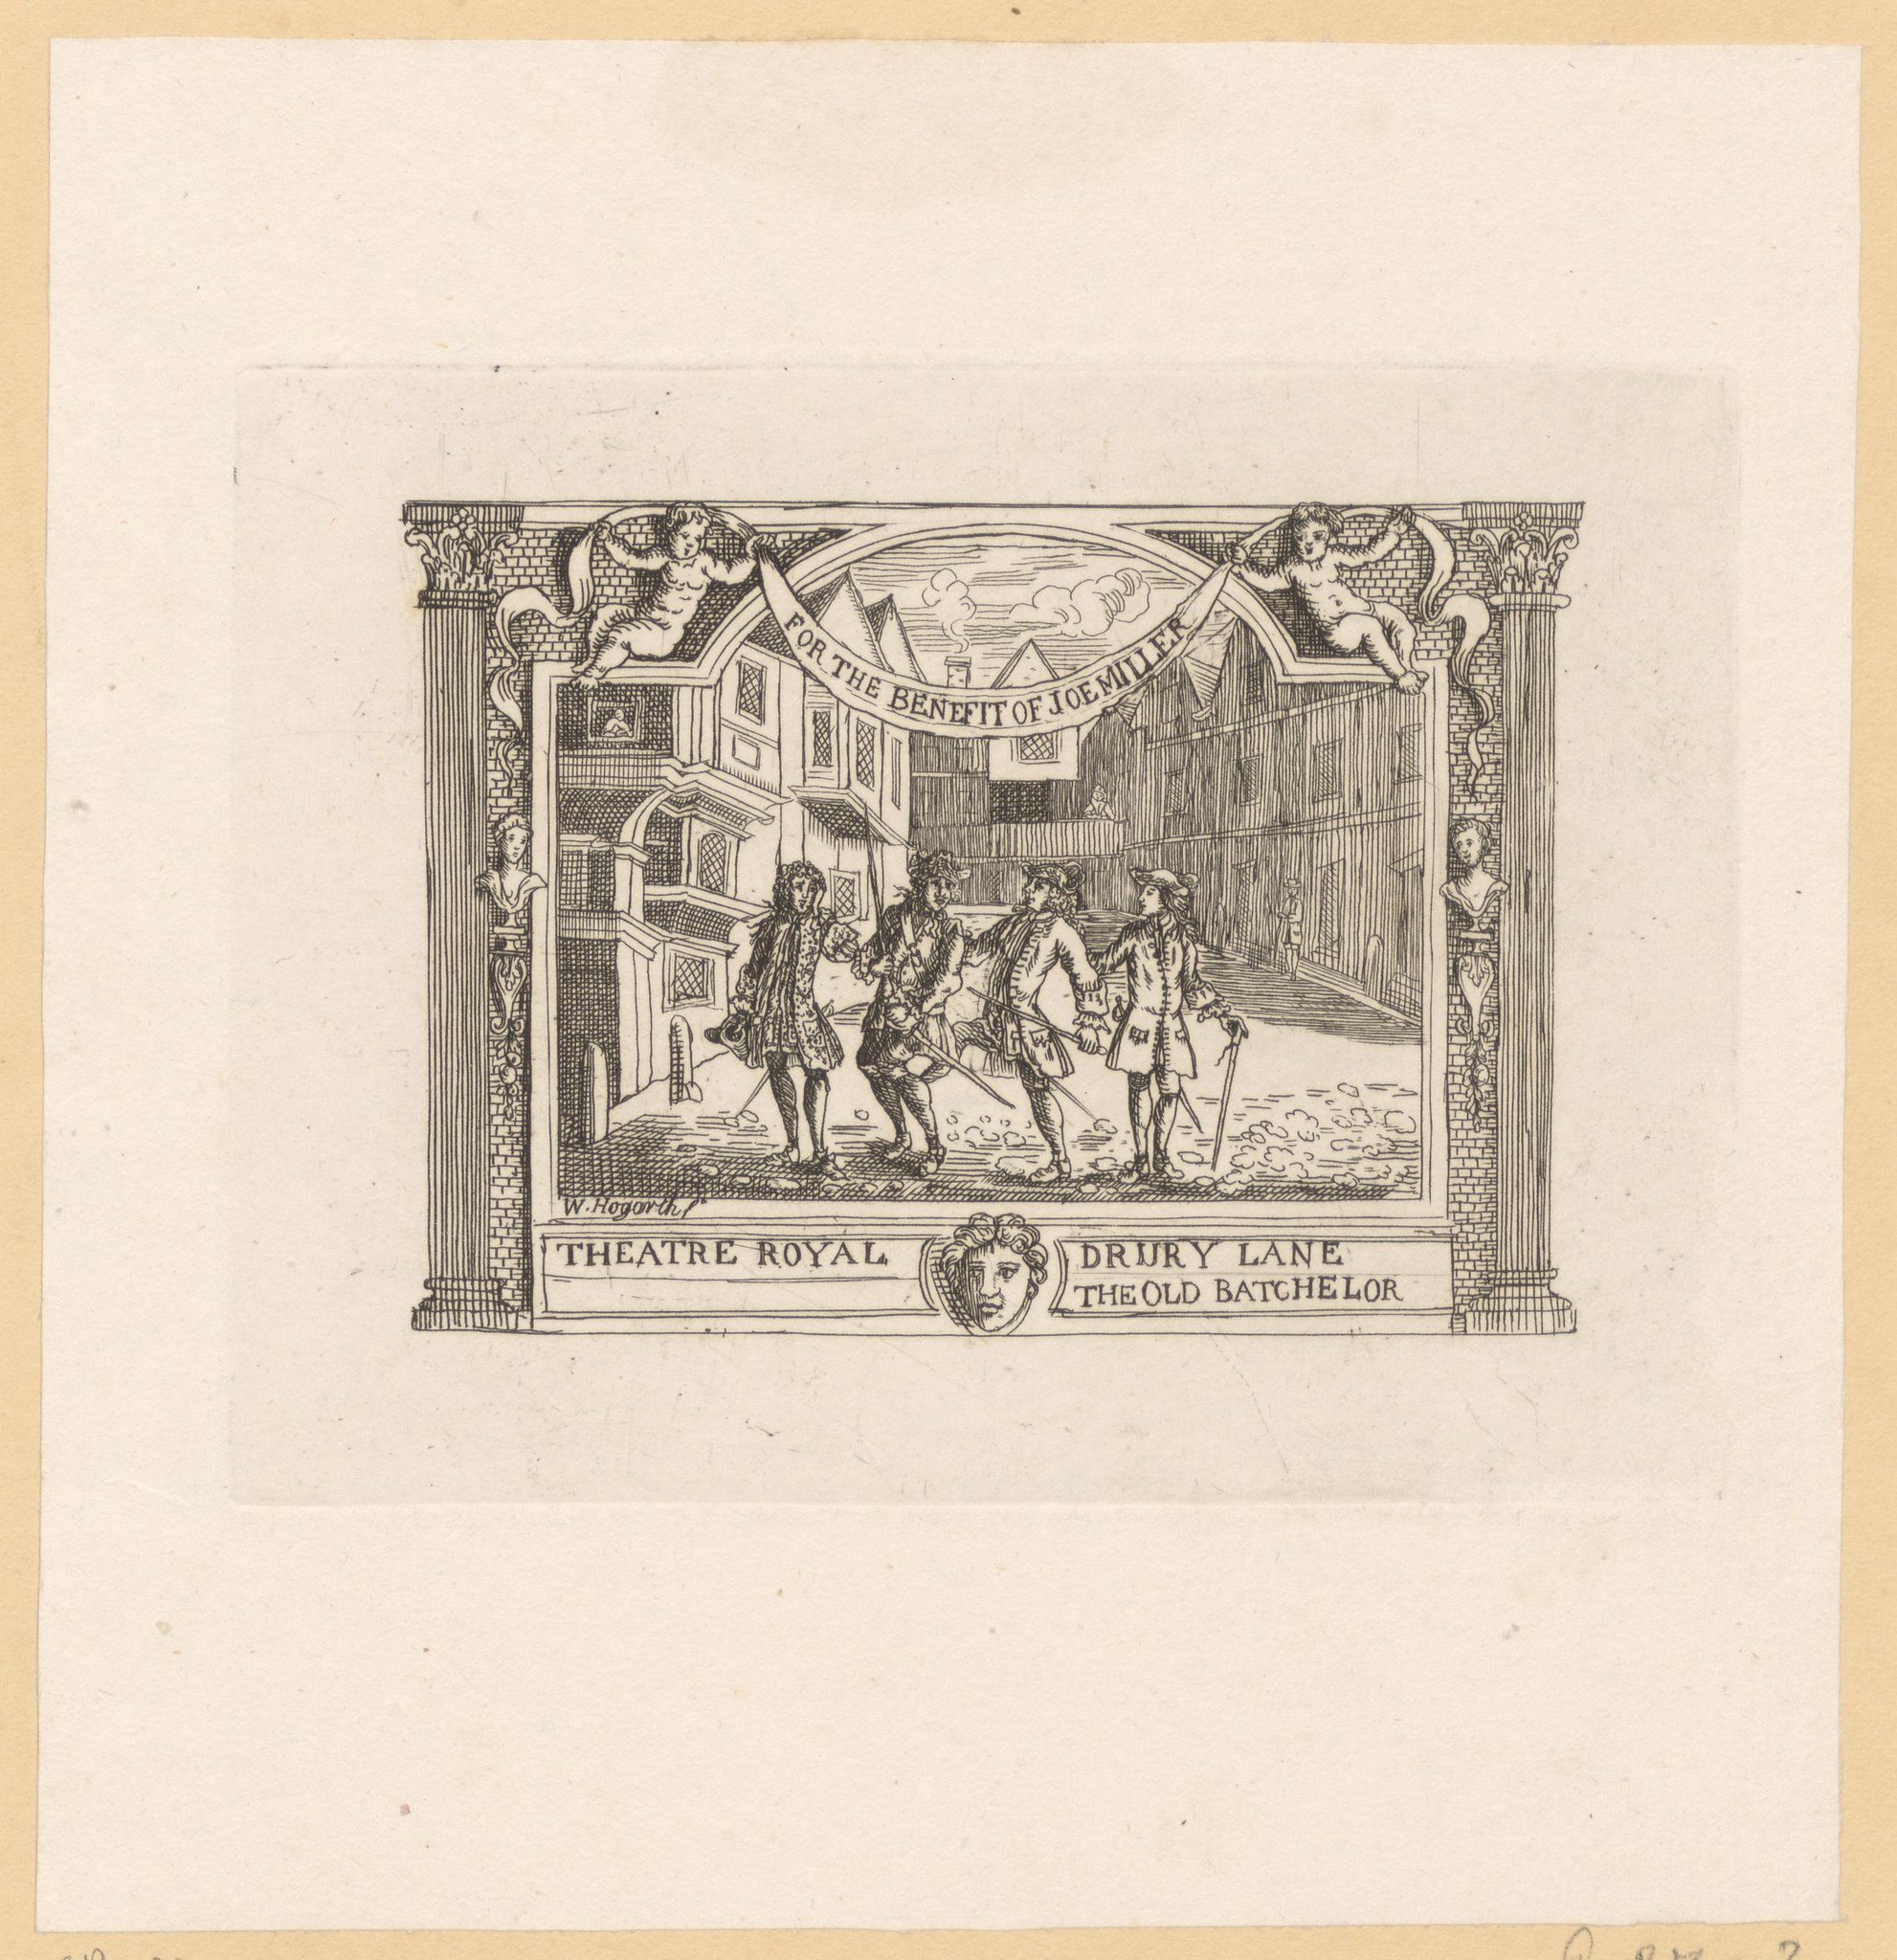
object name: print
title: Theatre Royal, The Old Batchelor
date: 1722-1738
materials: paper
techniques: etching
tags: theatre, theatrical performance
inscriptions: collector's mark: Lugt 2228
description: Tekst in het Engels in de banier en ondermarge. Het bedrijft toont act drie uit het toneelstuk 'The Old Bachelor' waarin Noll Bluffe, die het op Joseph Wittol voorzien heeft, geschopt wordt door Sharper.